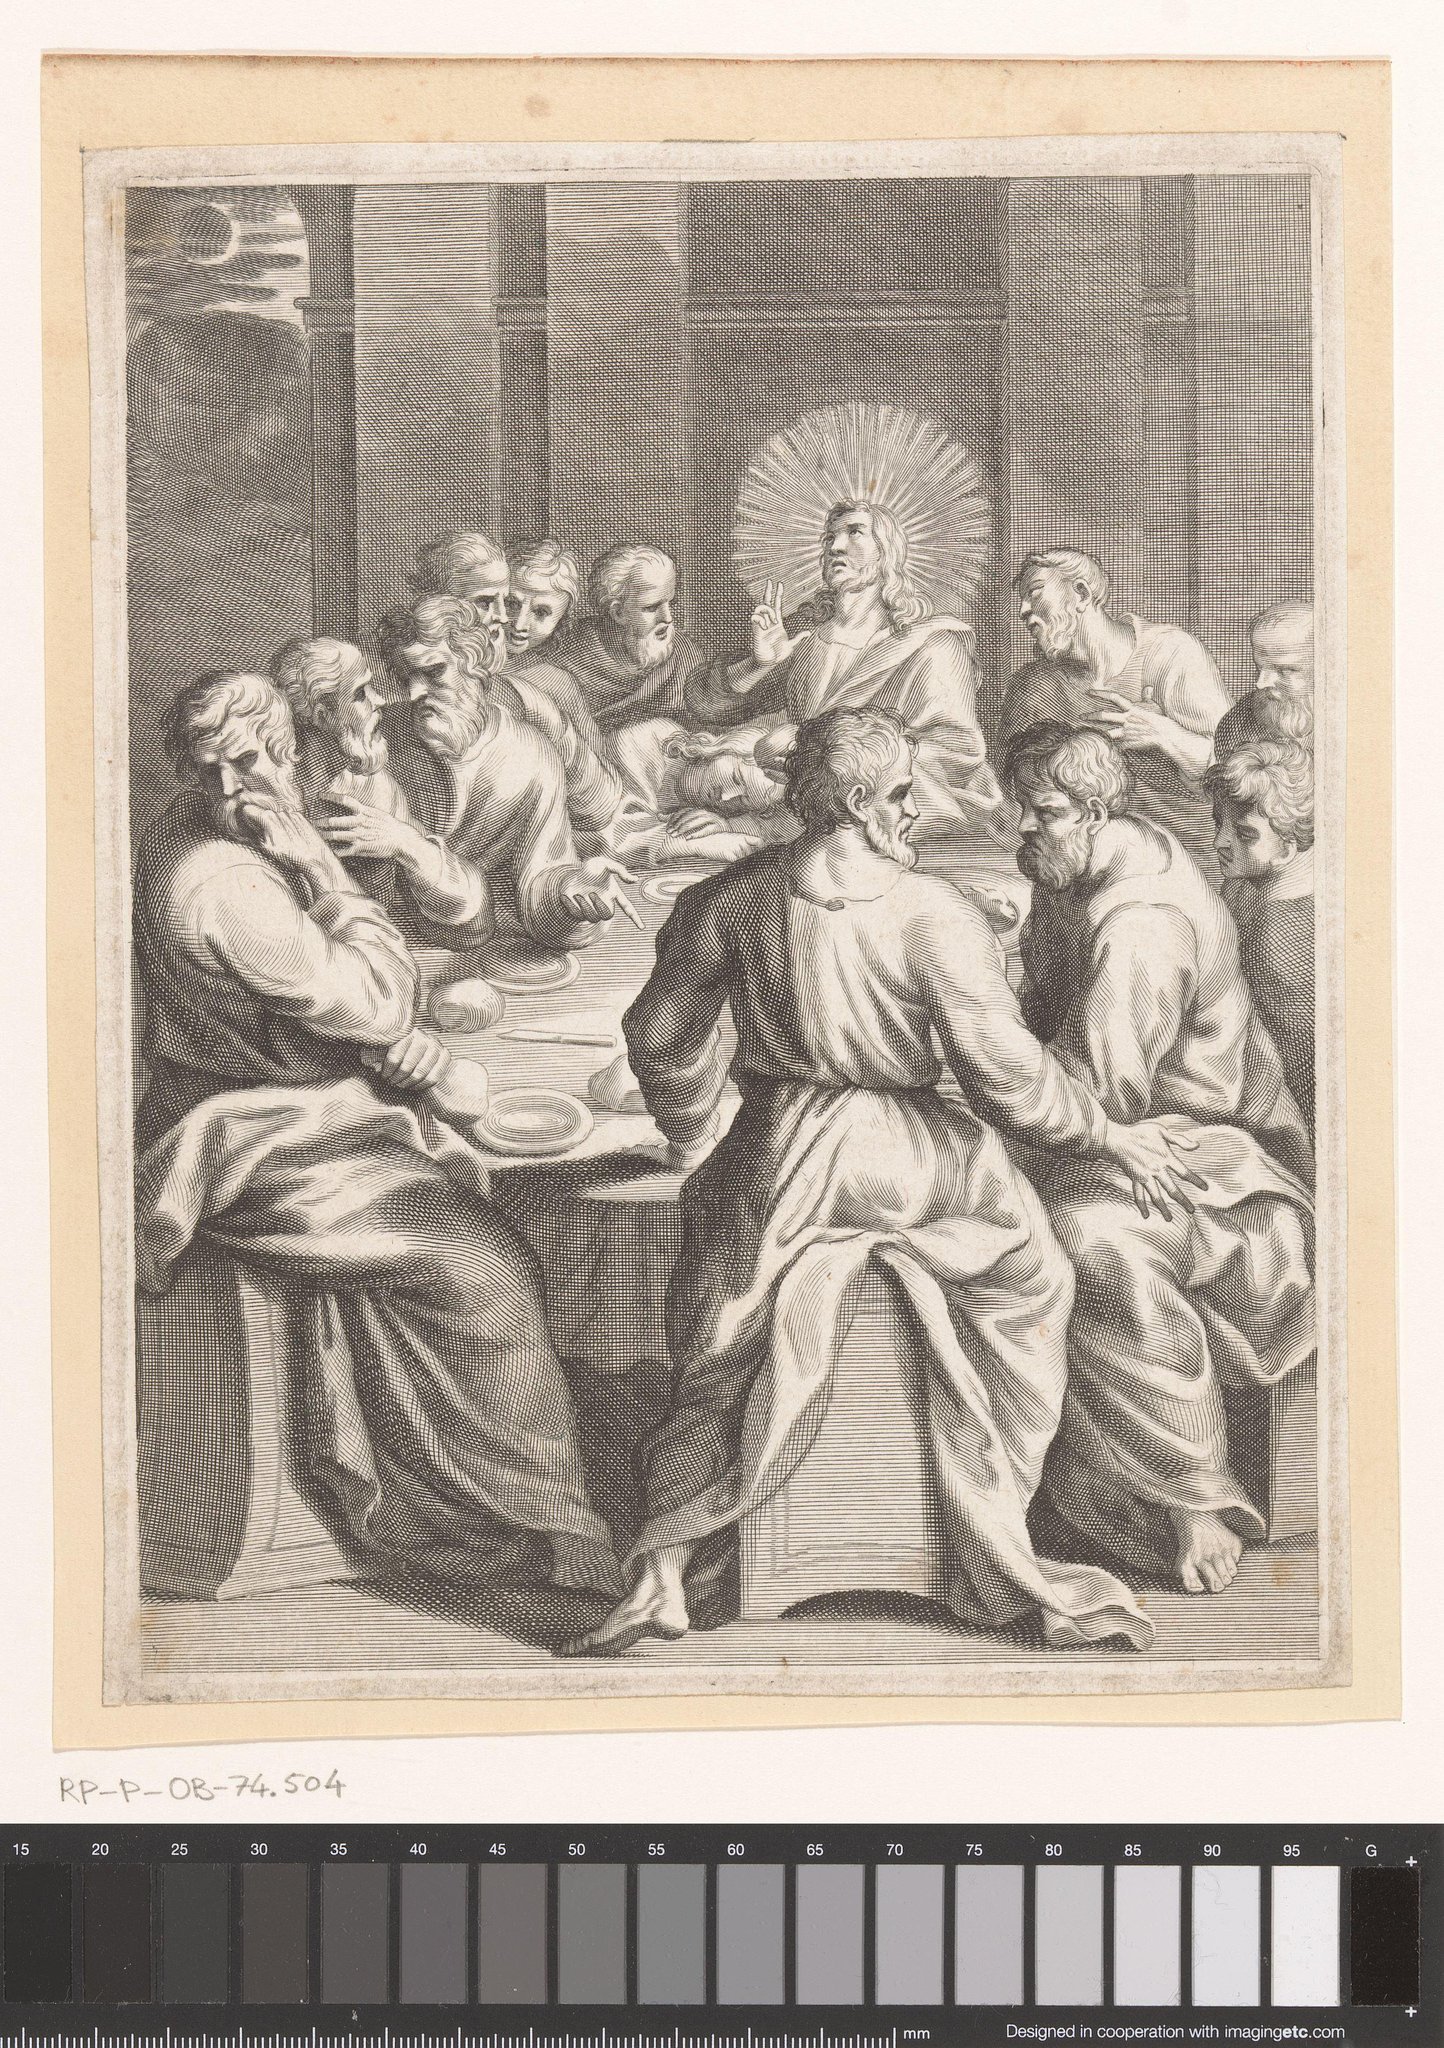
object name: print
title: Laatste Avondmaal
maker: benoît thiboust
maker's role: print maker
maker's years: 1619-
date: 1629-1729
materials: paper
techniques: engraving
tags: last supper (in general) (matthew 26:21-35; mark 14:18-31; luke 22:3, 22:15-23; john 13:21-38)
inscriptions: collector's mark: Lugt 240